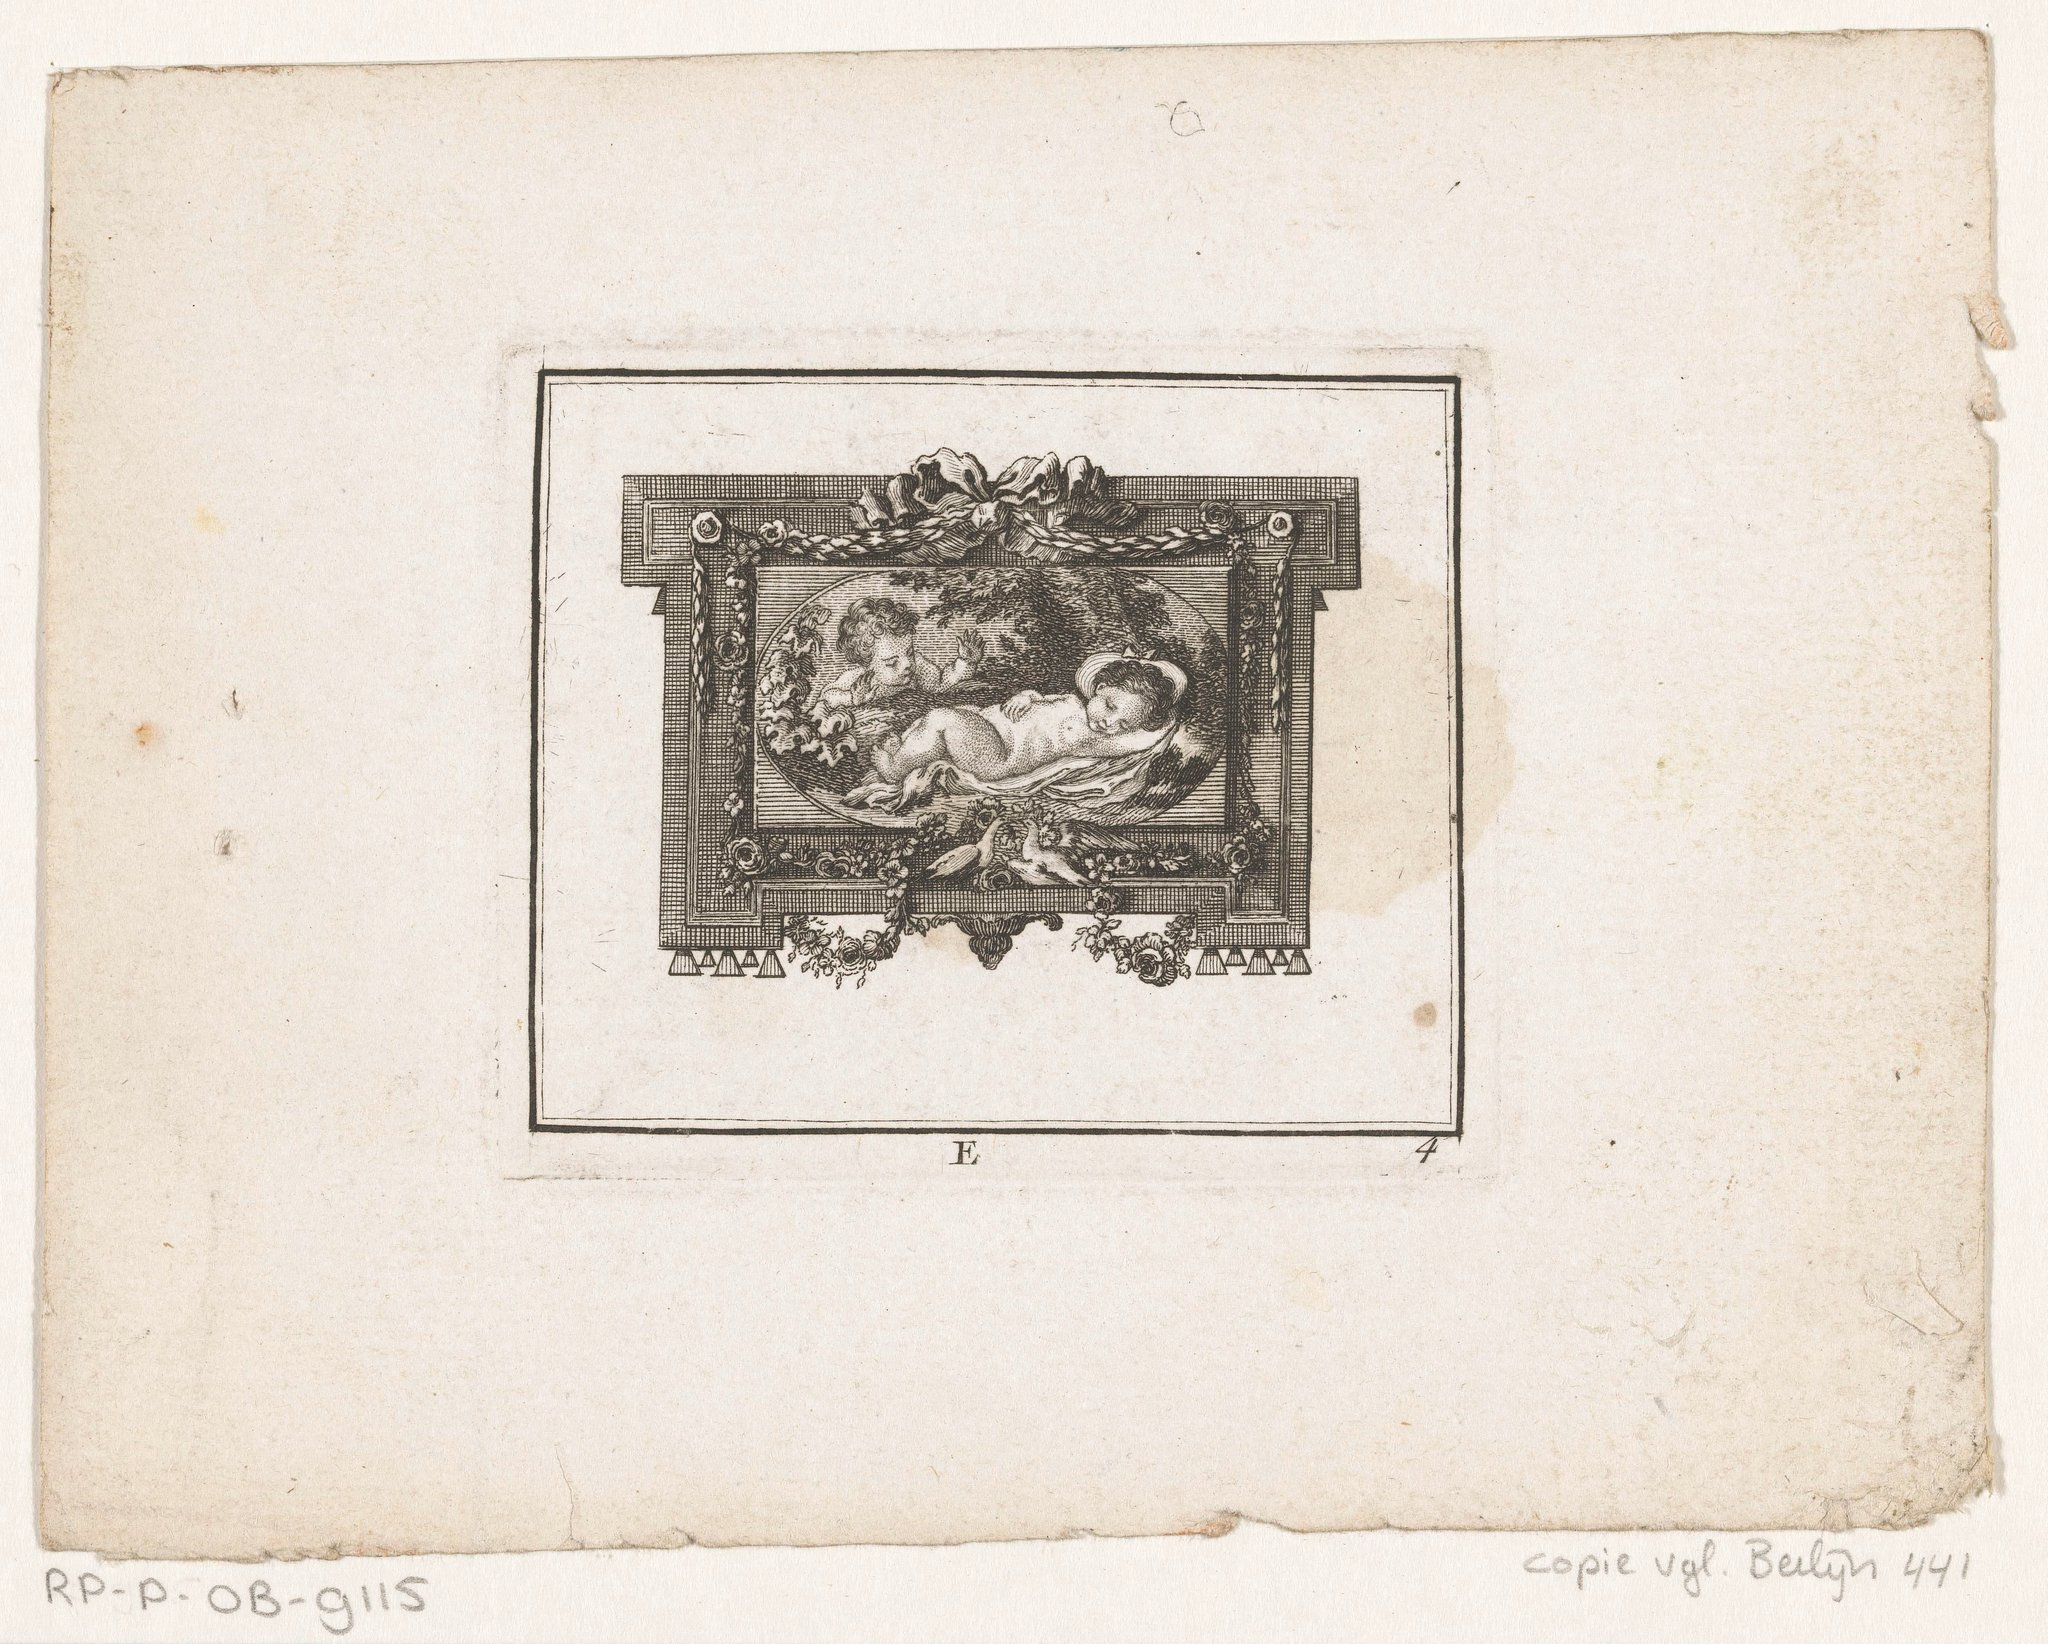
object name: print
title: E Culs de Lampe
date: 1730-1778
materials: paper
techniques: engraving, etching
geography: paris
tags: sleeping; unconsciousness, vignette, cupids: 'amores', 'amoretti', 'putti'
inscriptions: collector's mark: Lugt 2228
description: Vignet met twee putti in een rechthoekige omlijsting. De putto links kijkt naar de slapende putto op de voorgrond.